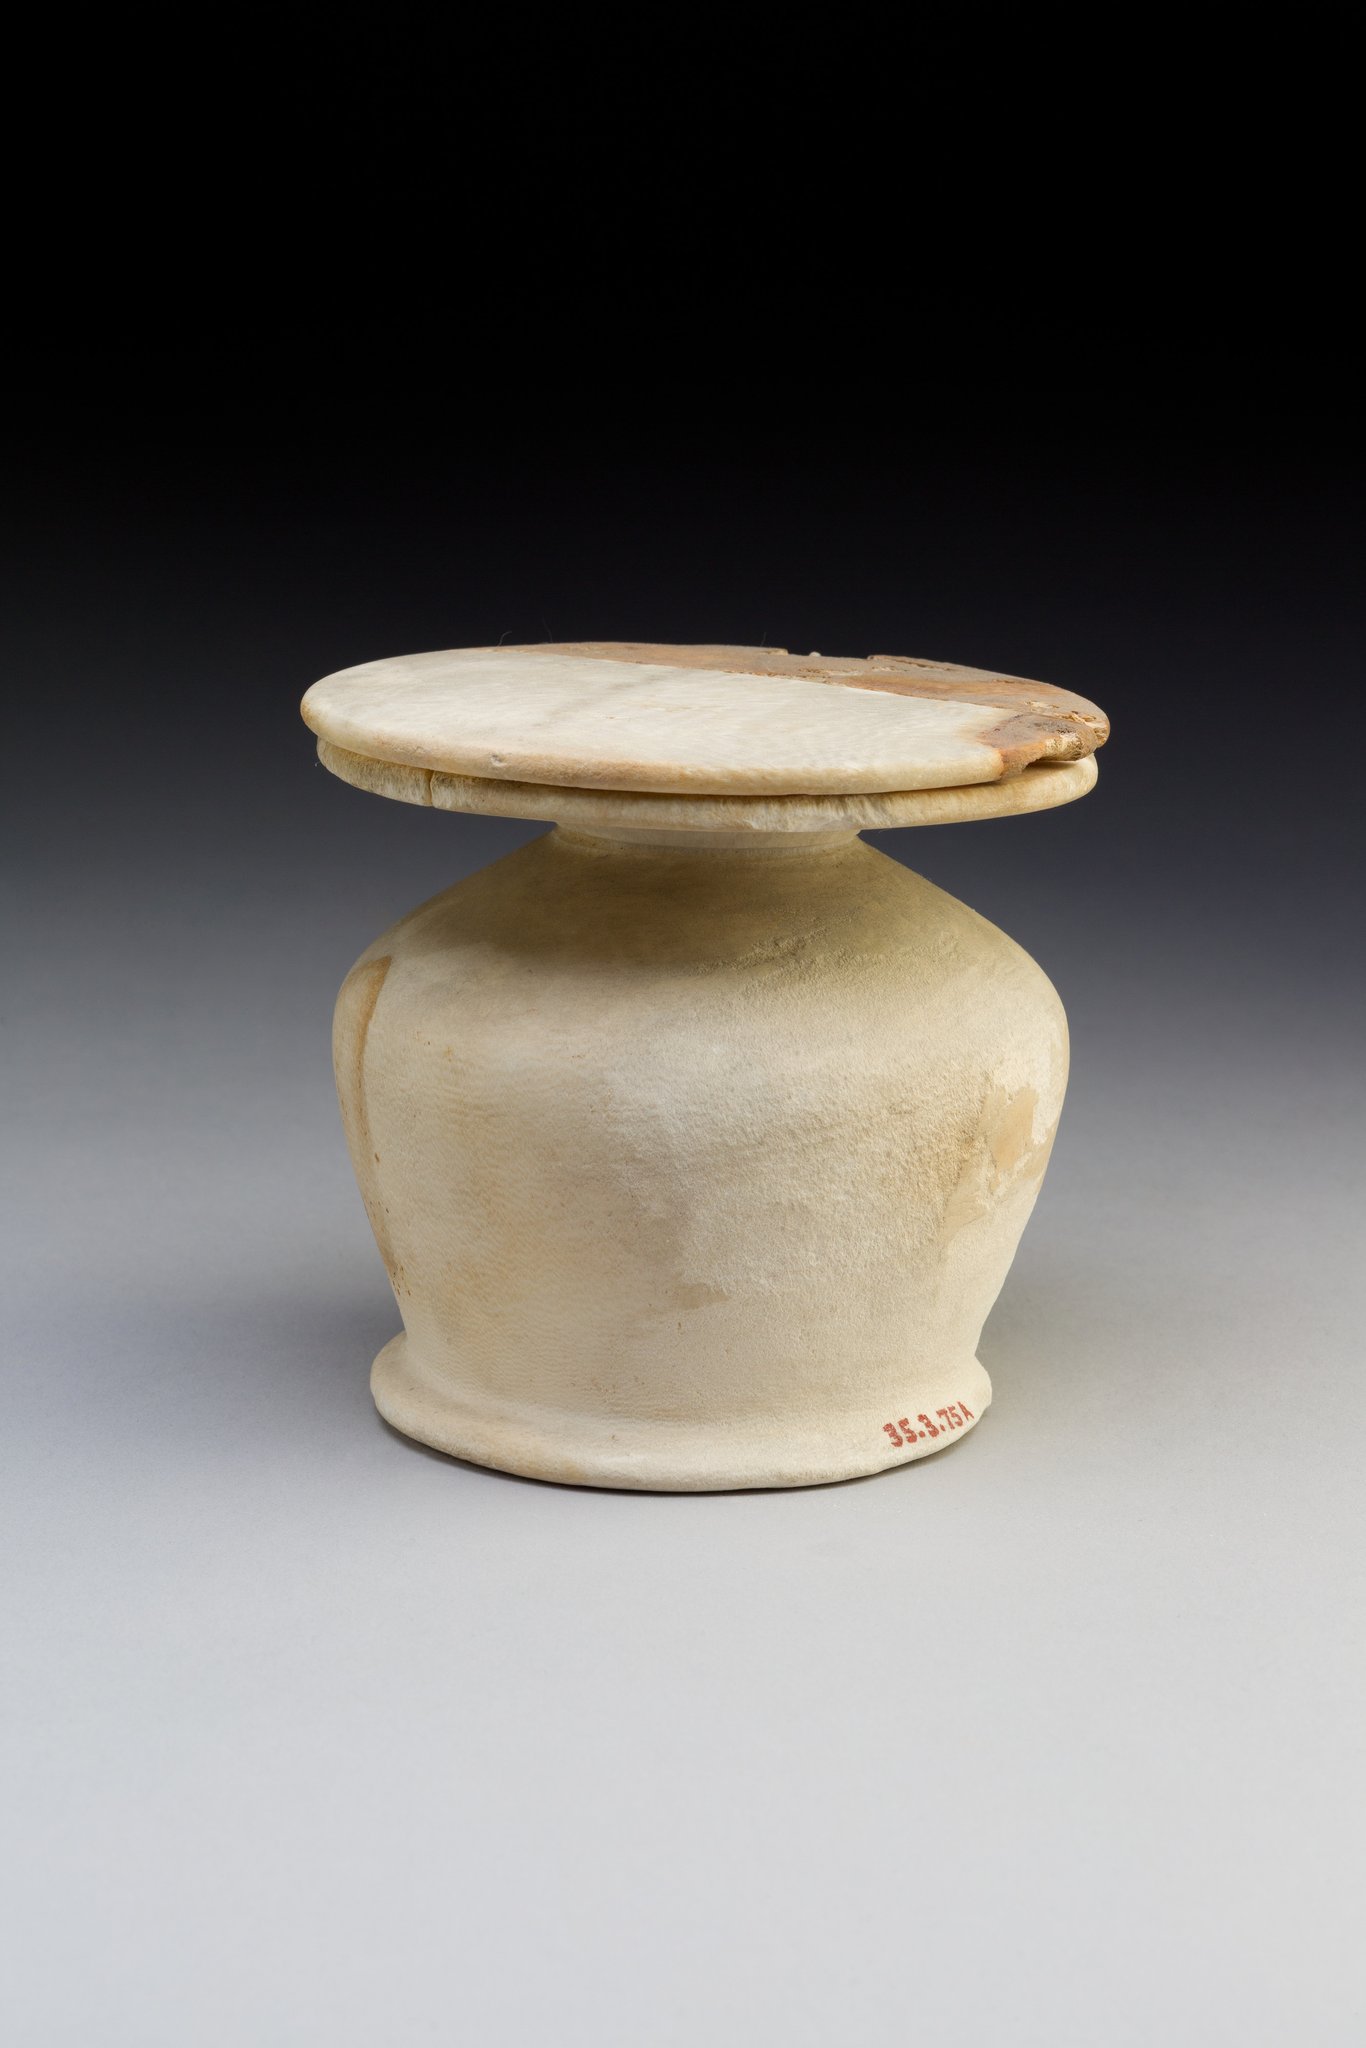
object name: kohl jar, rennefer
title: Kohl Jar of Rennefer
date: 1504-1447 BCE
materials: stone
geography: egypt